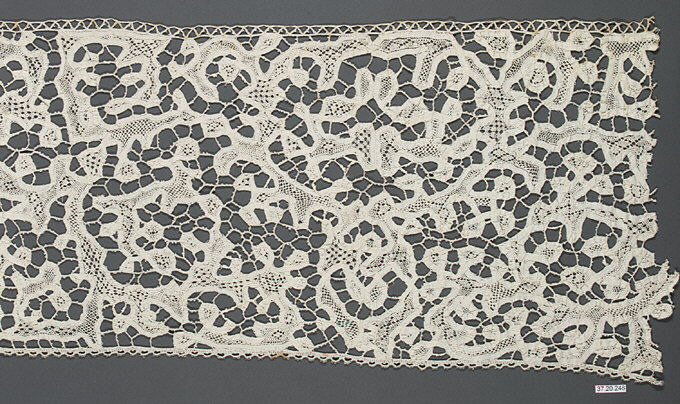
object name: border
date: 1701-1800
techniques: lace